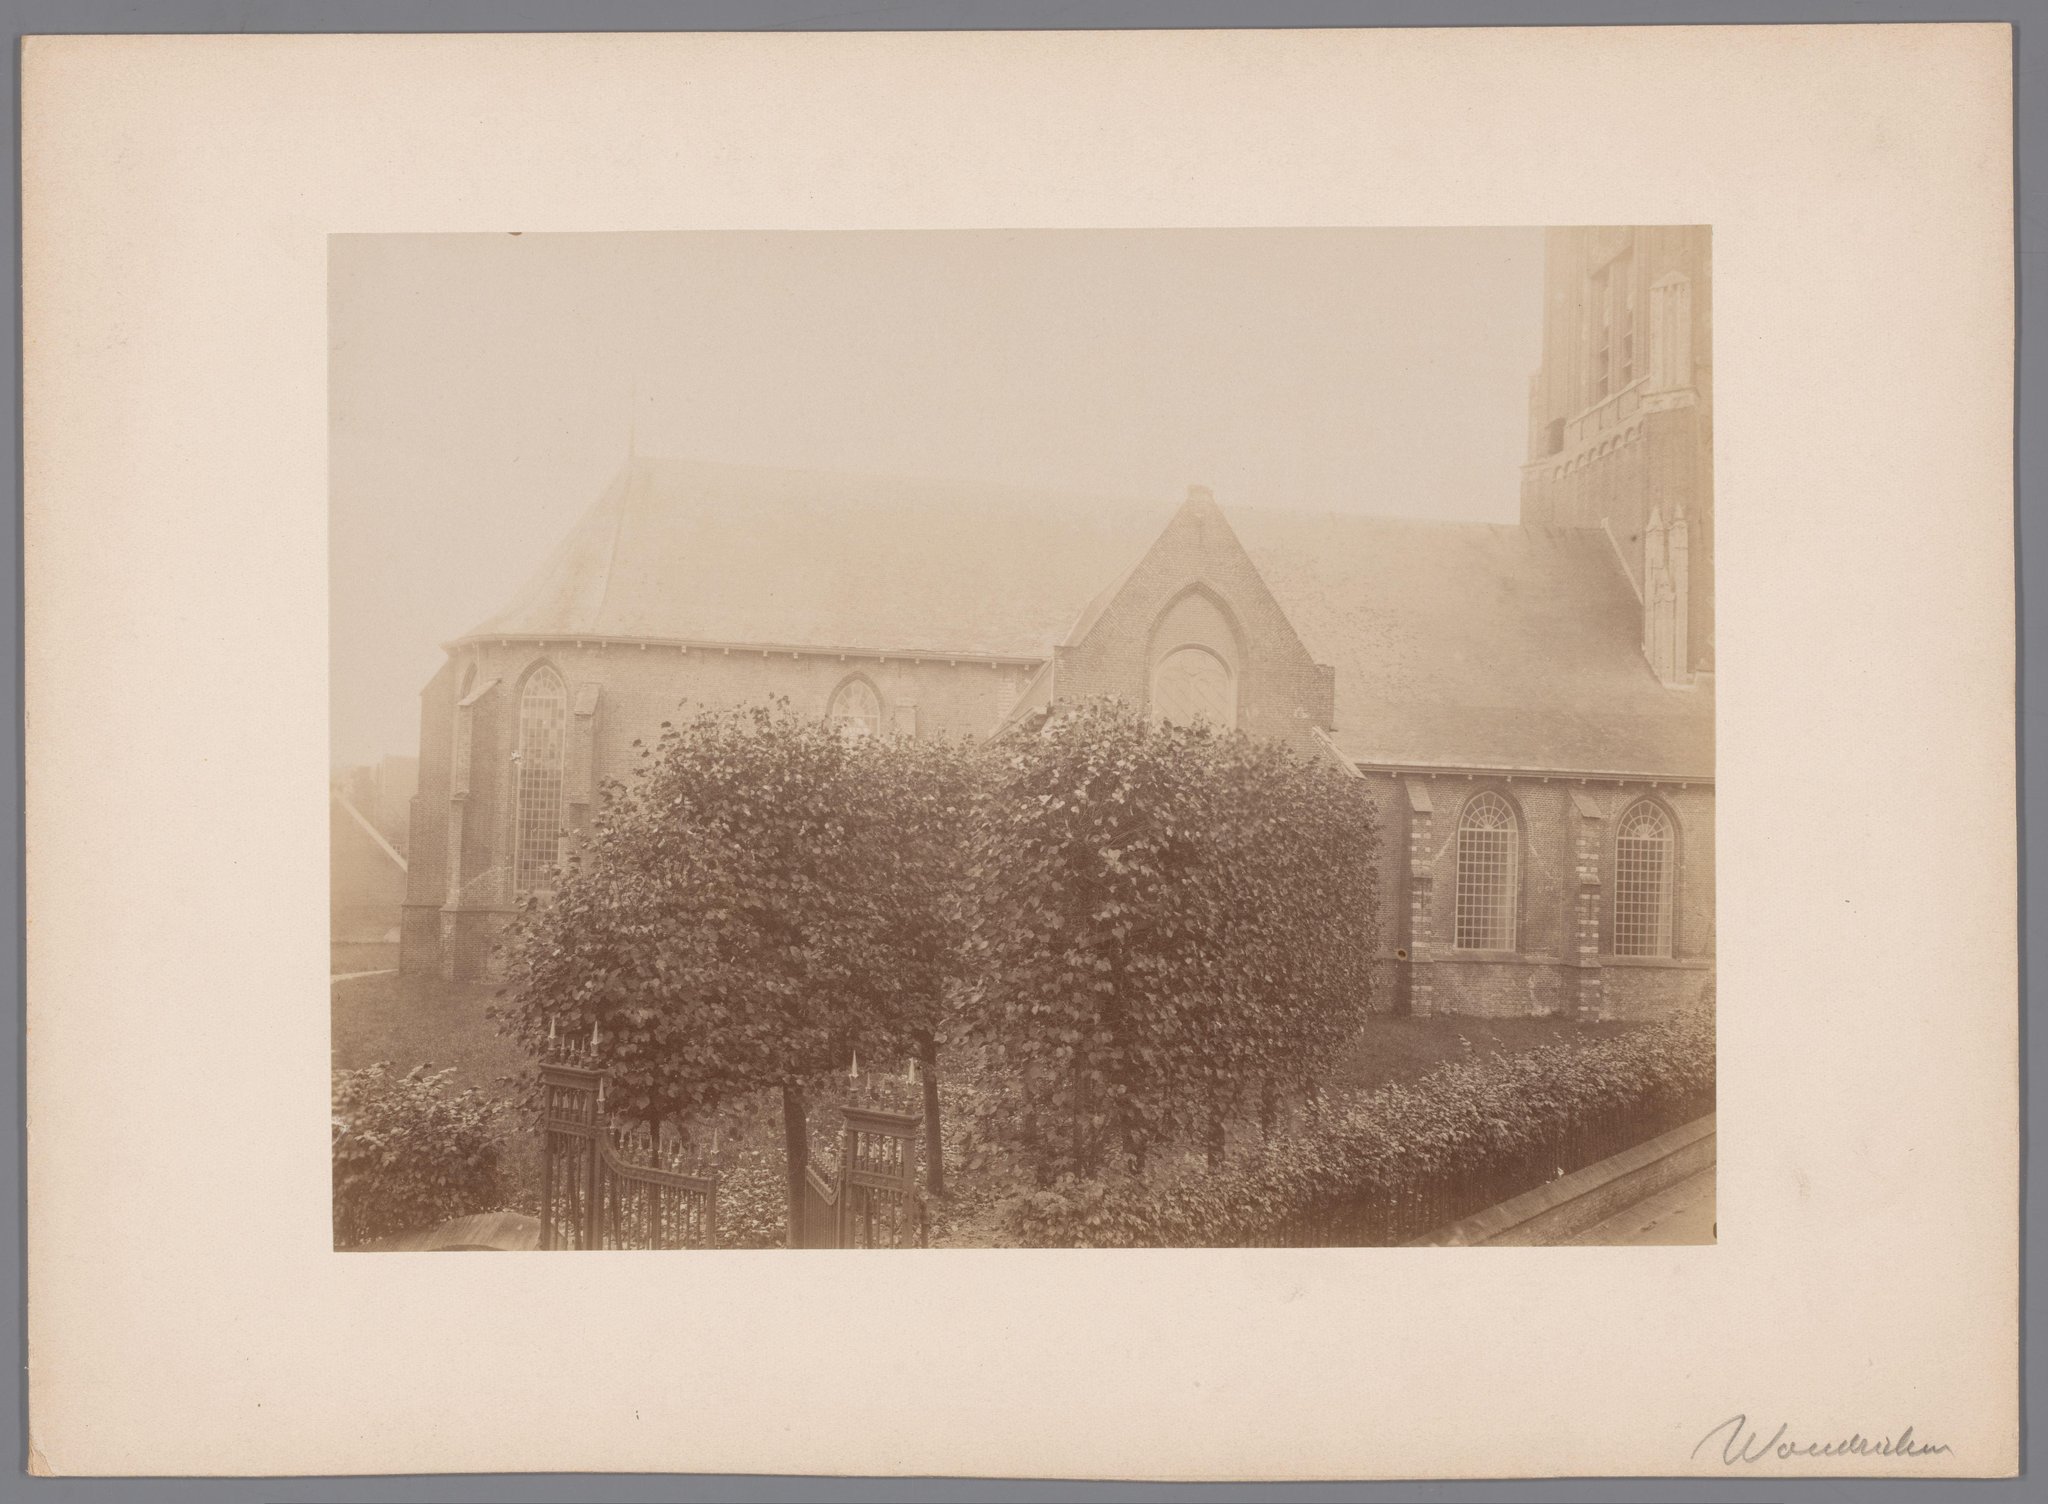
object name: photograph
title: Noordzijde van de Sint-Martinuskerk te Woudrichem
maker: anoniem (monumentenzorg)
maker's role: fotograaf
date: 1901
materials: cardboard, photographic support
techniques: albumen print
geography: woudrichem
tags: church (exterior)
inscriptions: annotation: ‘Woudrichem’, annotation: ‘Woudrichem (N.B.)/ Noordzijde der N.H. kerk/ oct 1901’